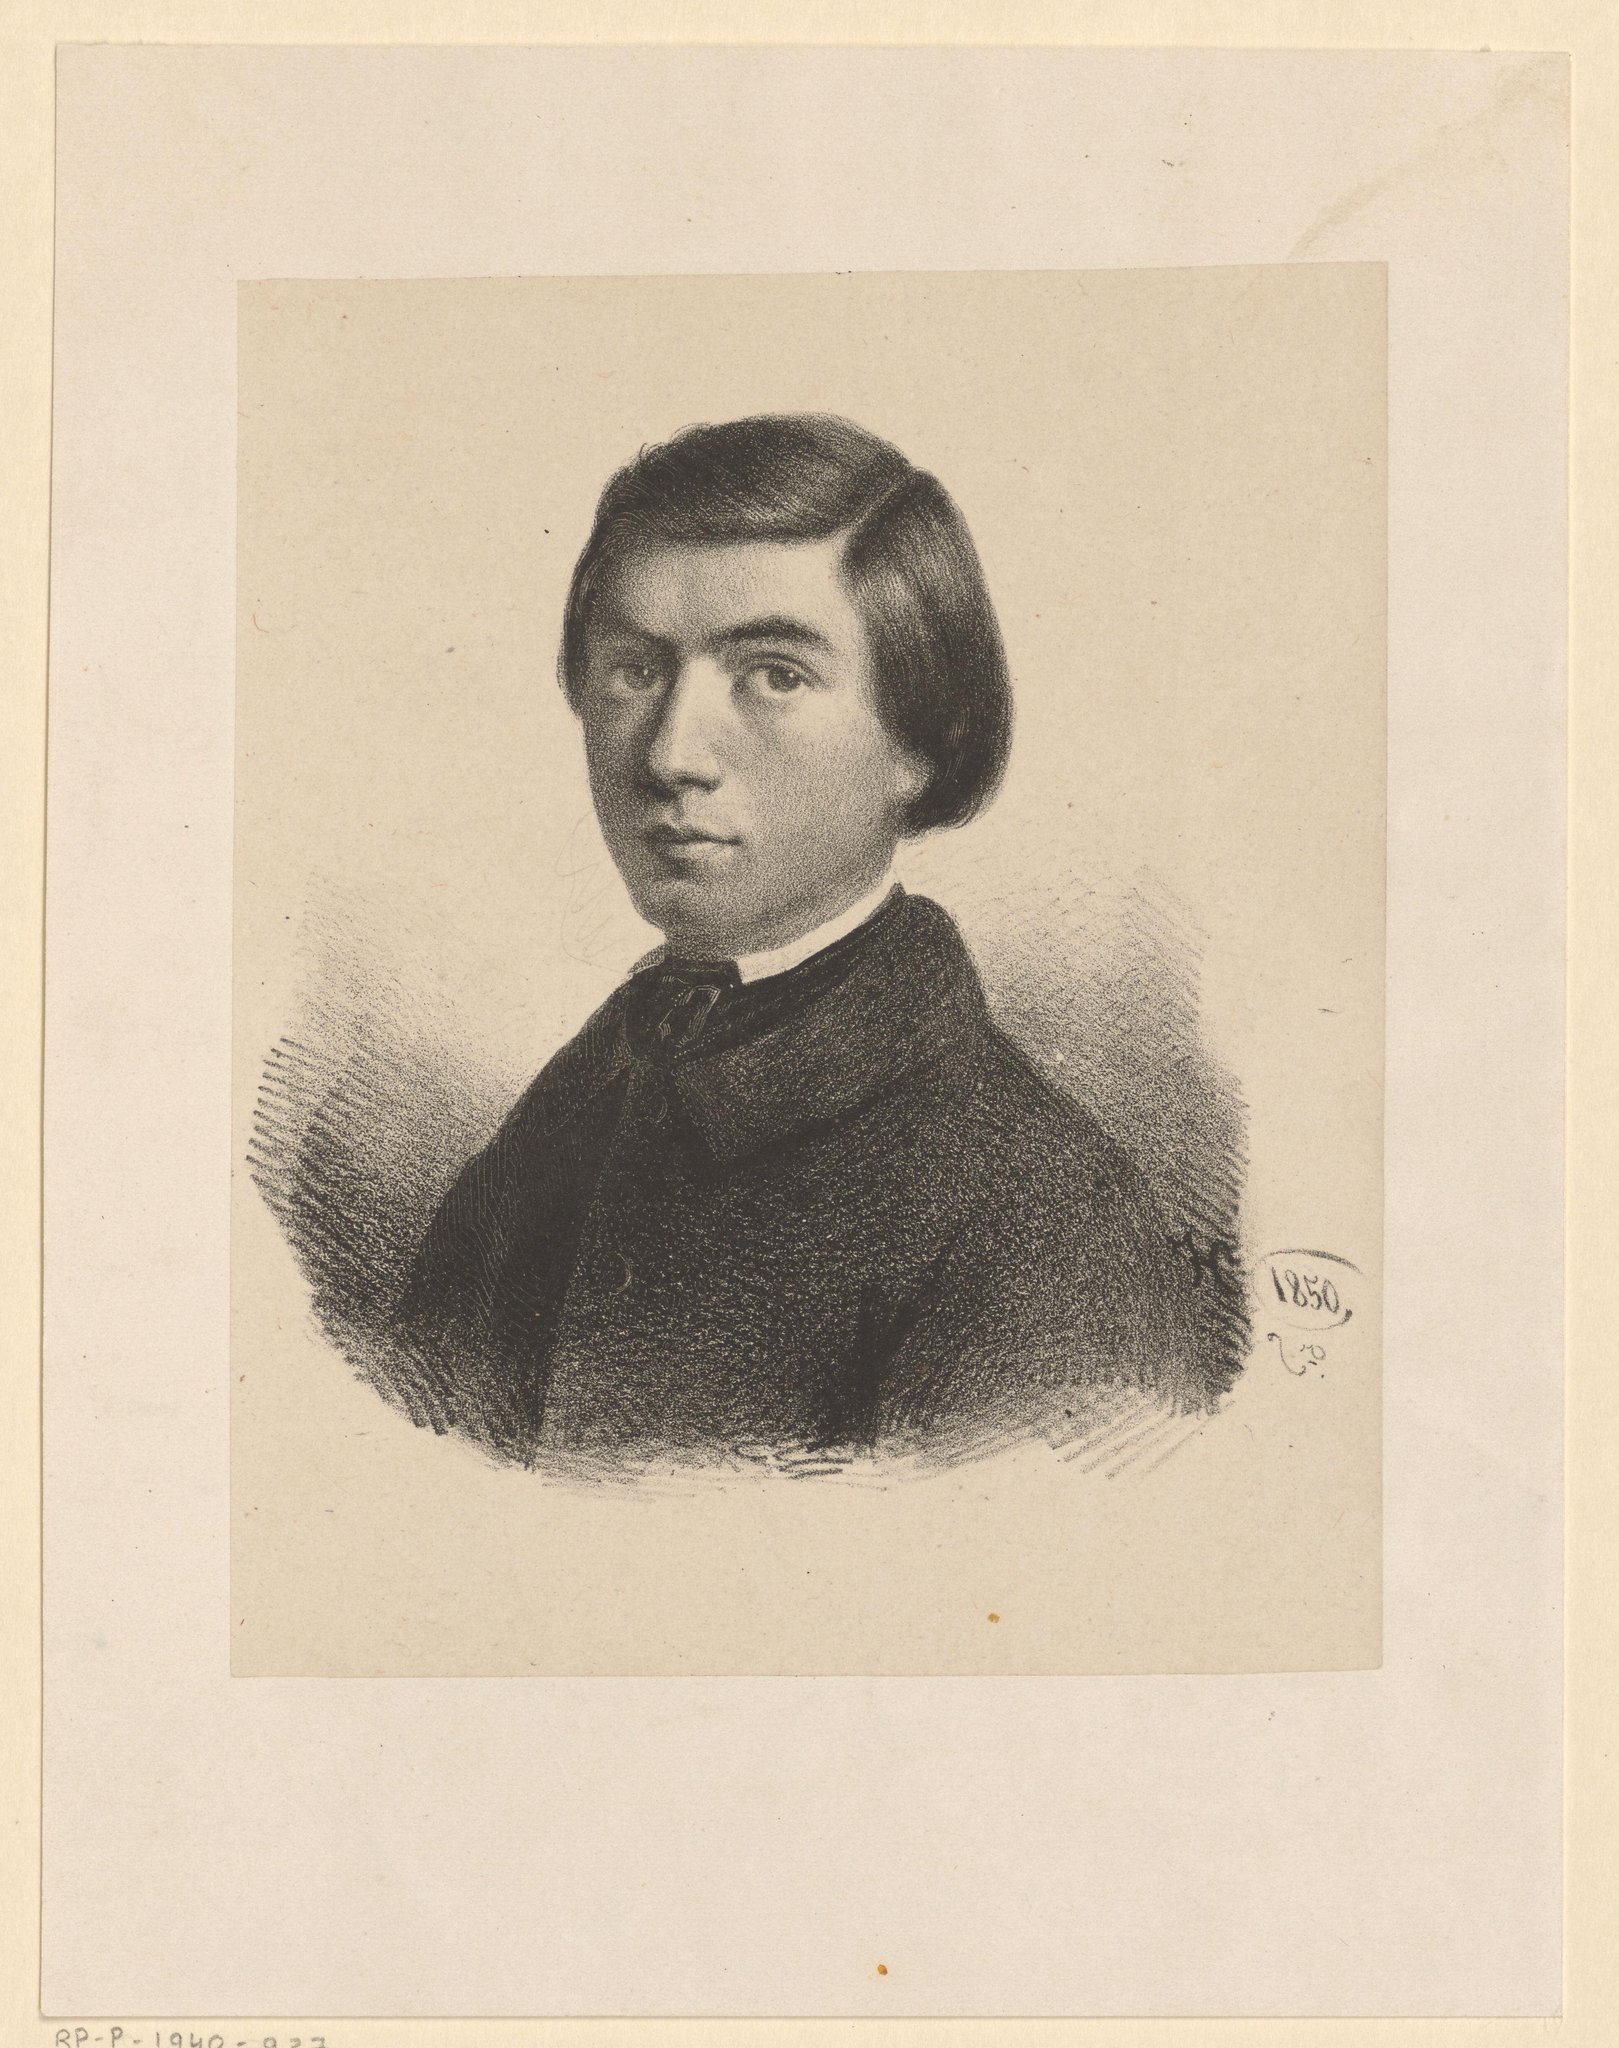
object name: print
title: Zelfportret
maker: hendricus joannes petrus hanau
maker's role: painter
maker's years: 1830-1900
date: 1850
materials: paper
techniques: lithograph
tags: utrecht, painter, hendricus joannes petrus hanau, historical persons, portrait, self-portrait of artist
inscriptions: inscription: ‘Slechts 12 exemplaren bestaan/ van dit portret en zijn door/ H. Hanau aan zijne vrienden/ bij zijn vertrek naar Antwerpen/ geschonken. Niet in de handel.’, collector's mark: Lugt 2760, collector's mark: Lugt 2228